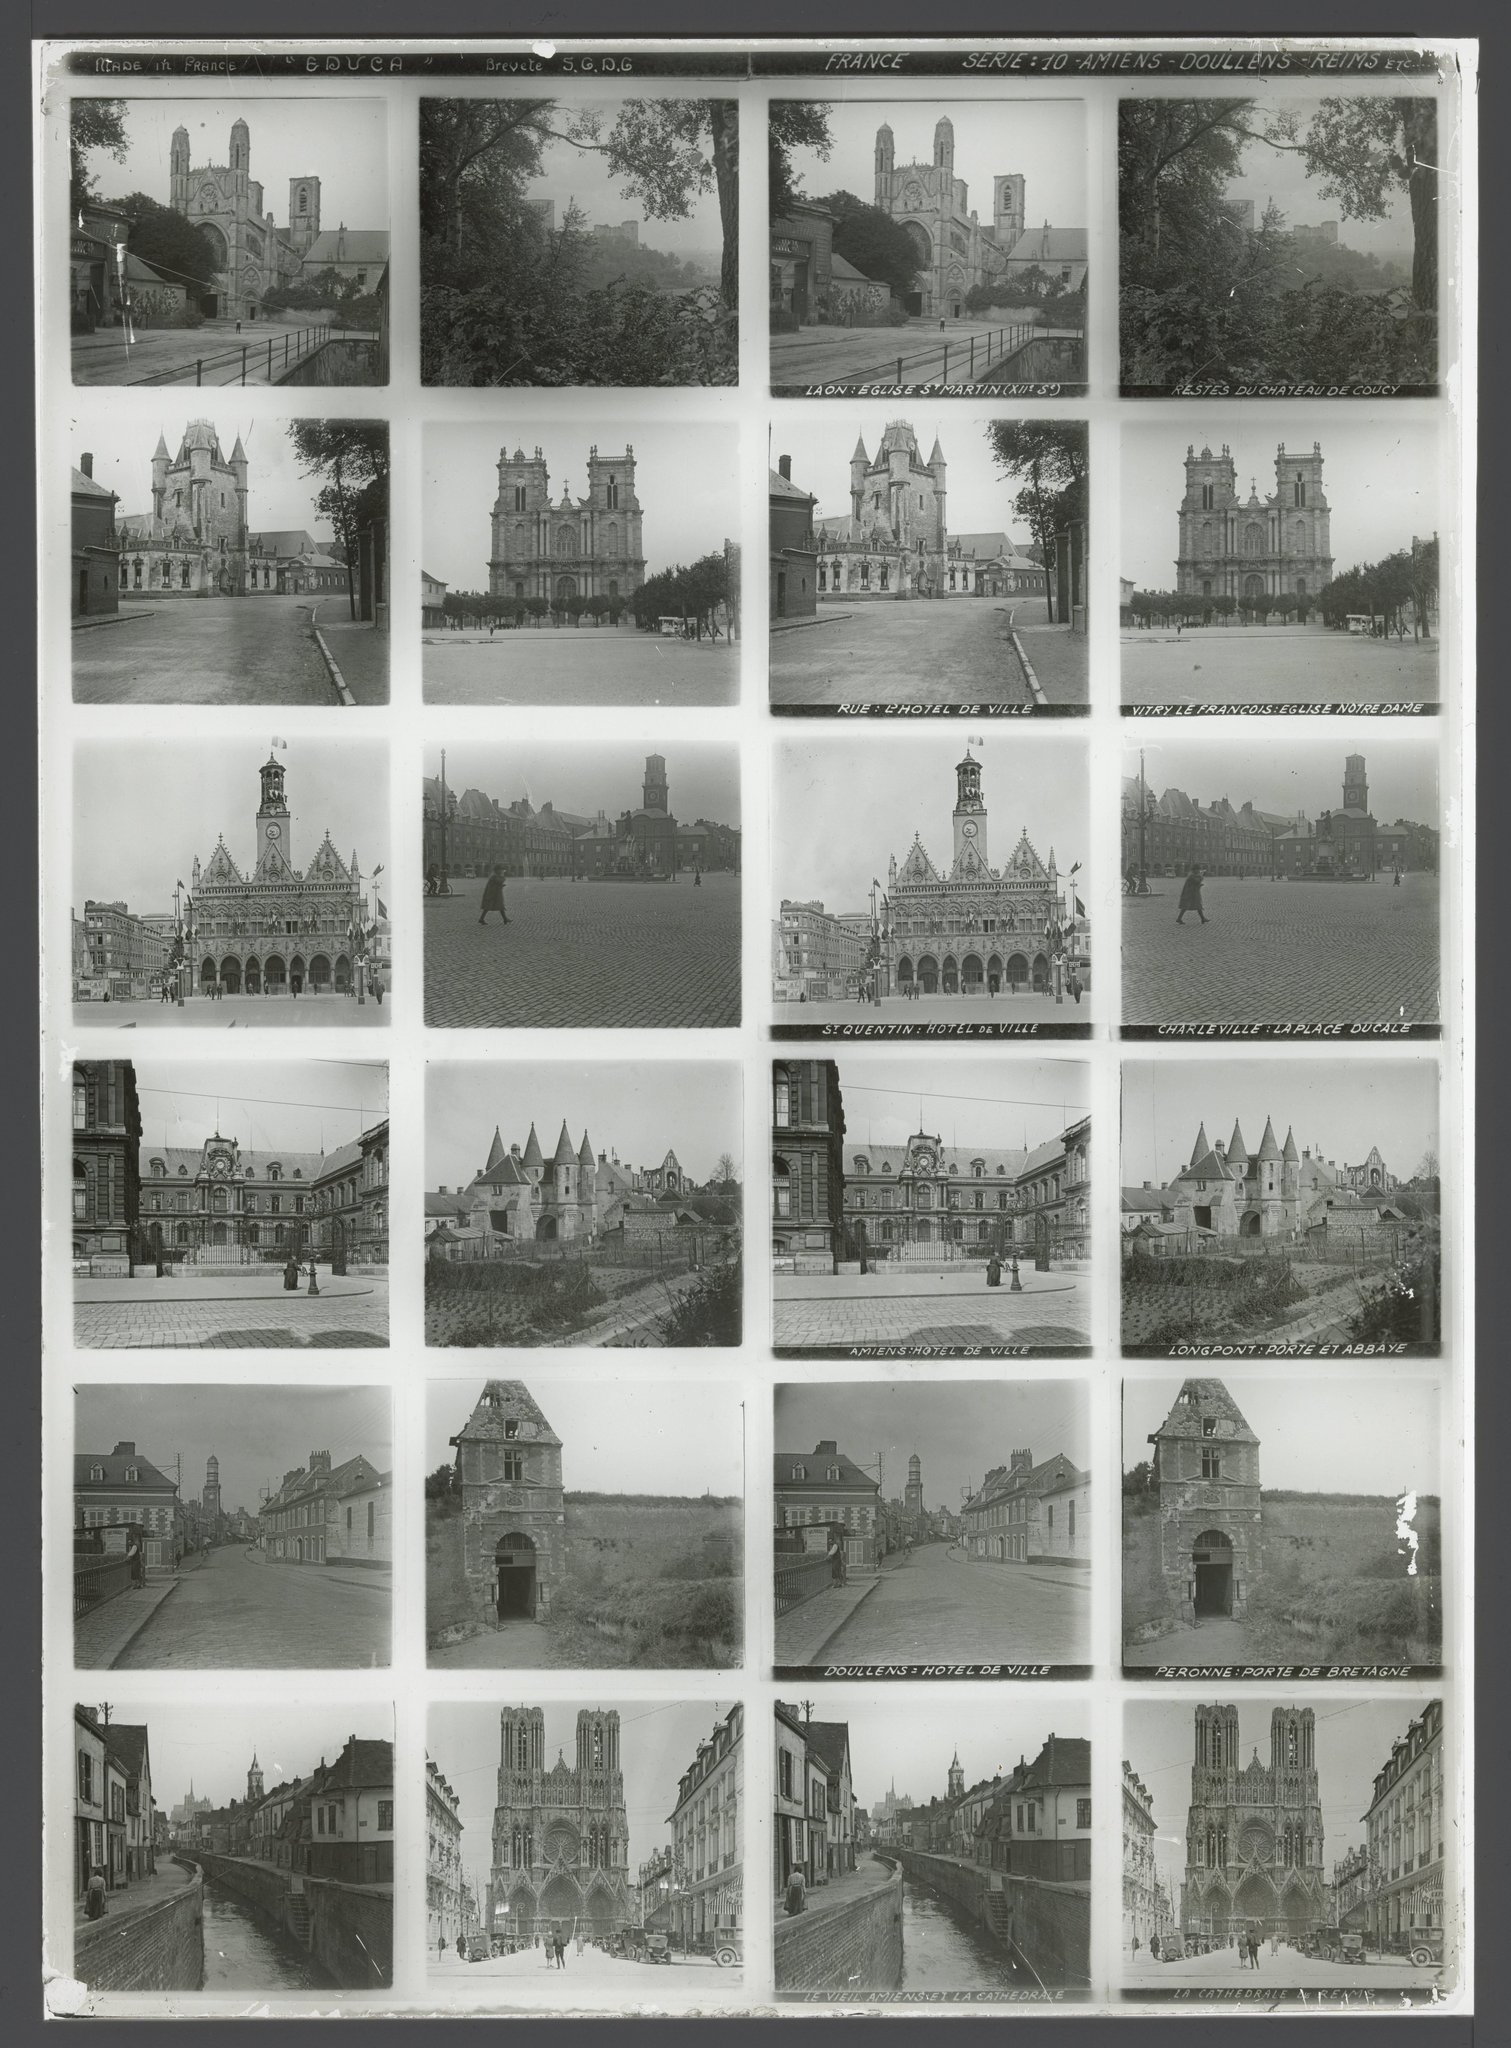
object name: stereoscopic photograph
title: France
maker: Anonymous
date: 1920-1925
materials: glass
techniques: gelatin silver transparency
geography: france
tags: square, place, circus, etc., palace, church (exterior), townhall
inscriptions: inscription: ‘Made in France (...) Brevete S.G.D.G. (...)’